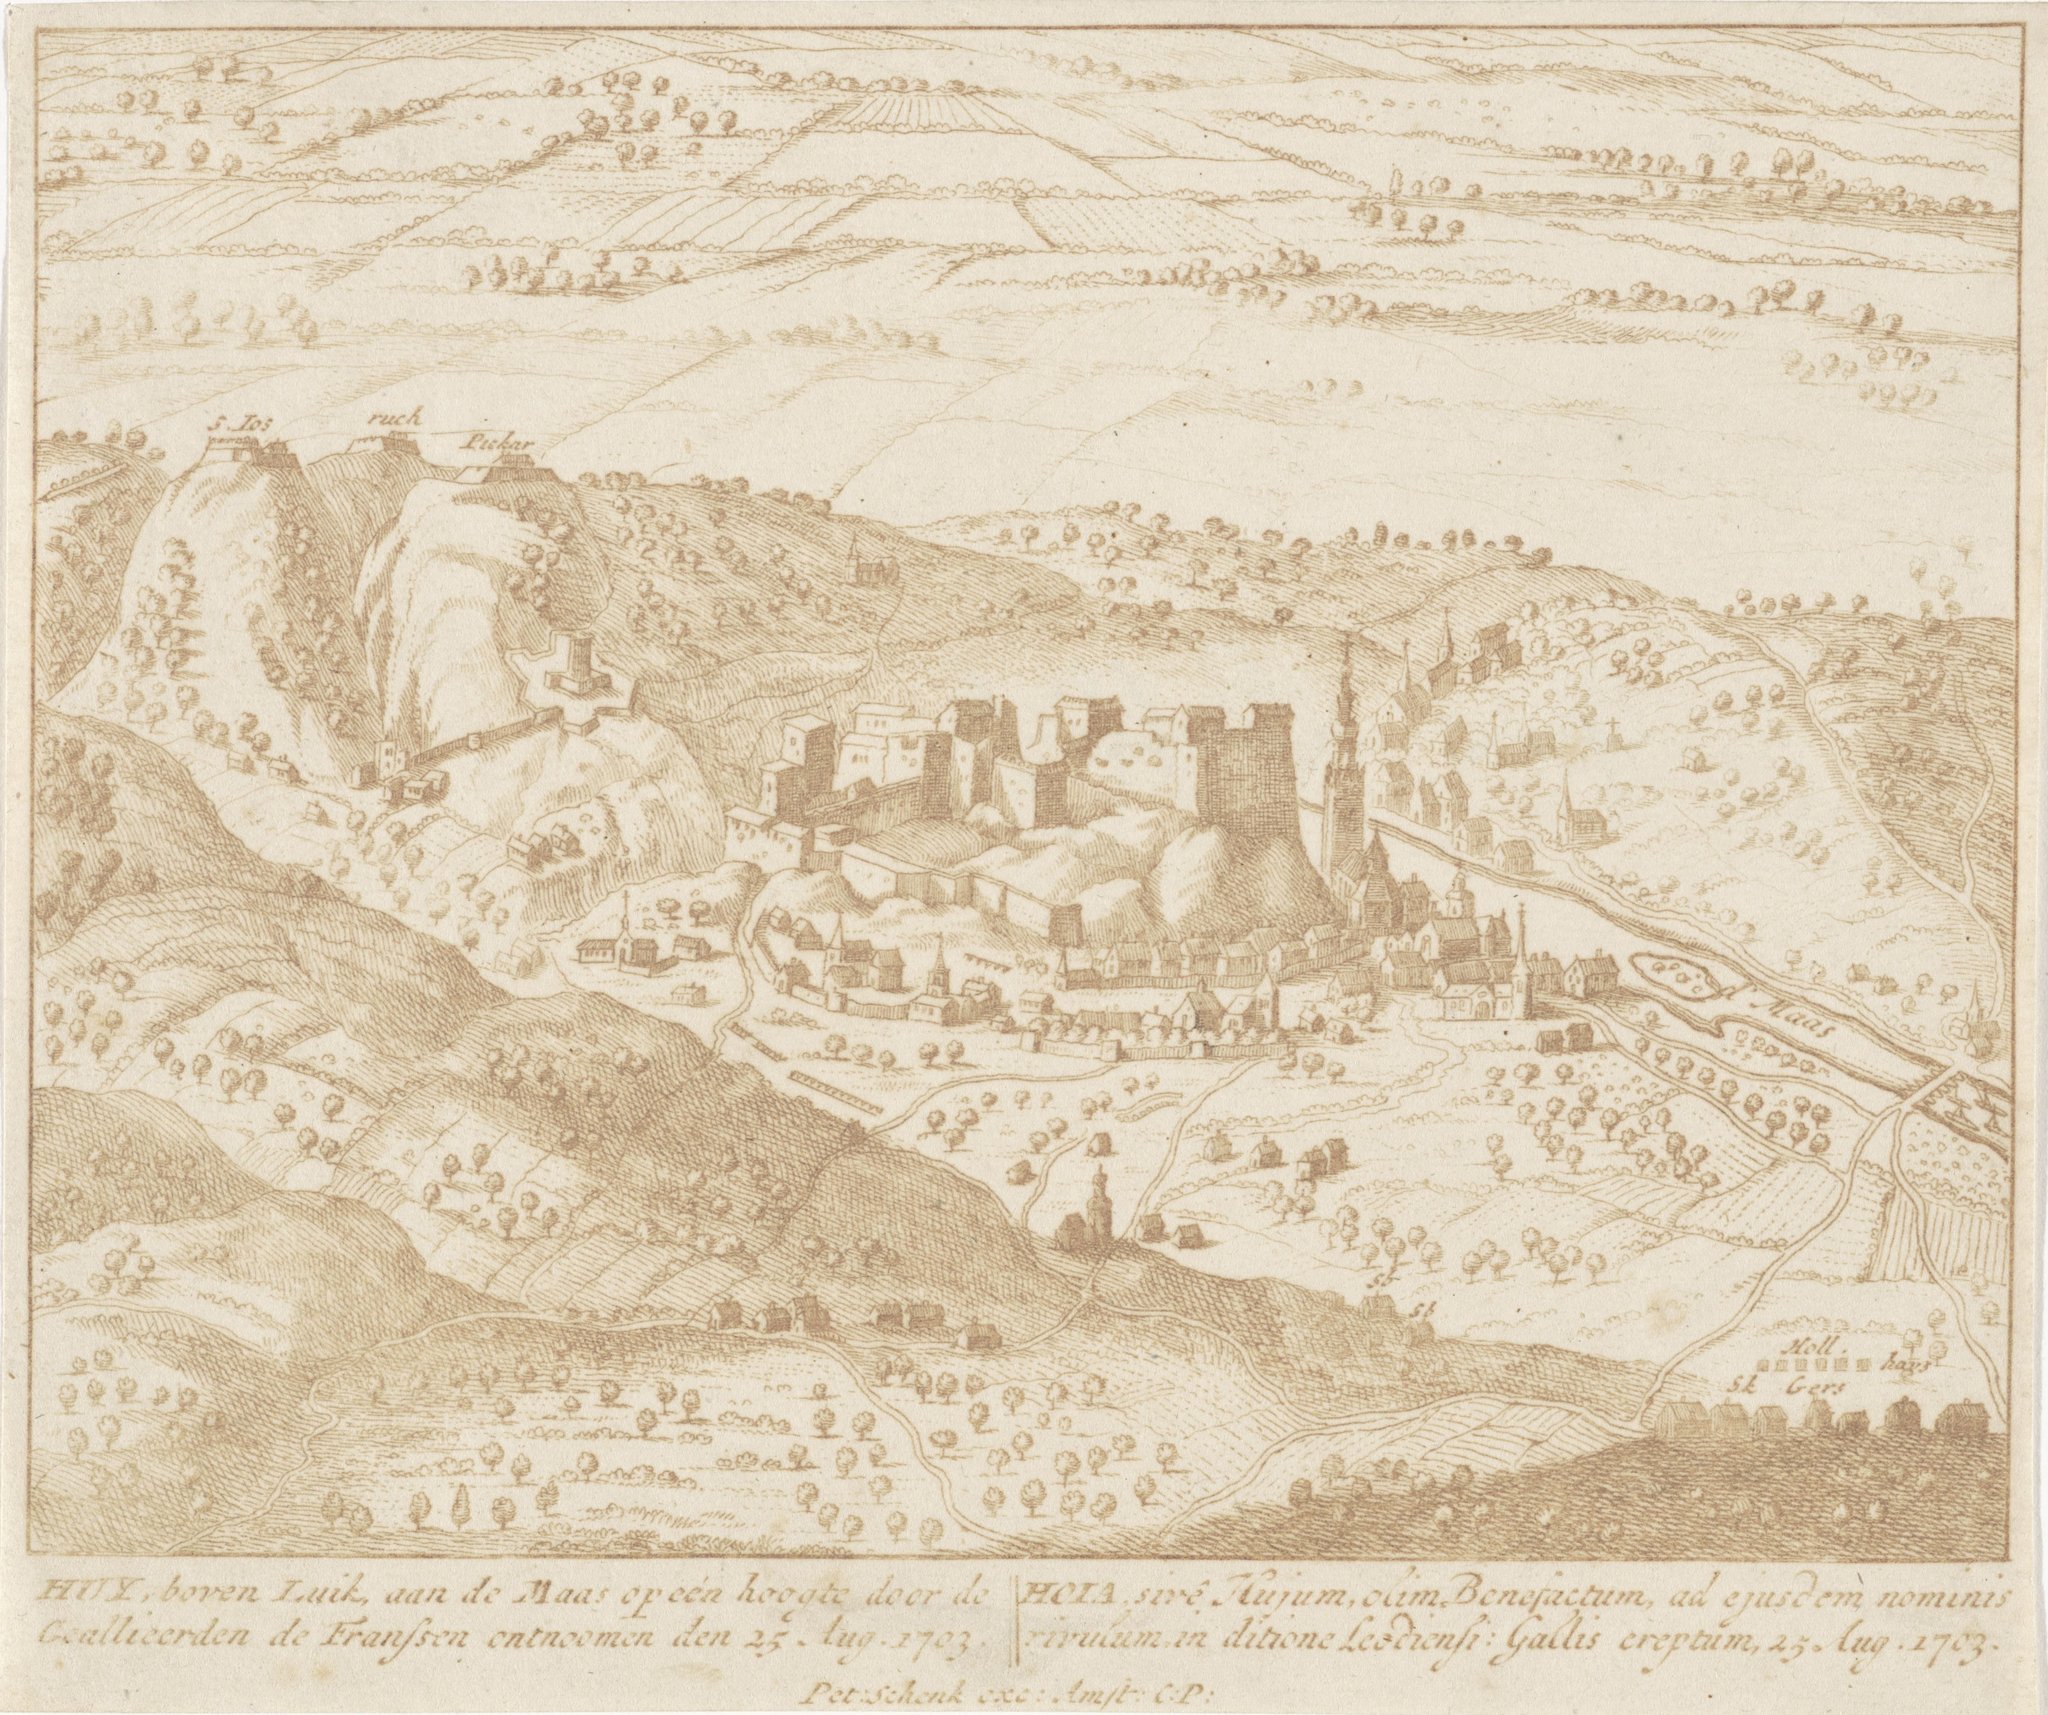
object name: book illustration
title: Schouwburg van den Oorlog, Beginnende van Koning Karel den II. Tot op Koning Karel den III. Bestaande in IX. Historische Figuren op een Olifants Blad, als Veldslagen, Belegeringen te Water en te Lande, met de voornaamste Vestingen (...)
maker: pieter schenk (i)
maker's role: print maker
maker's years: 1660-1711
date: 1706-1727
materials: paper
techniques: etching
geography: amsterdam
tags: landscapes in the temperate zone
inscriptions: collector's mark: Lugt 2228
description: Afbeelding op blad IV uit een van de edities van: Schouwburg van den Oorlog, Beginnende van Koning Karel den II. Tot op Koning Karel den III. Bestaande in IX. Historische Figuren op een Olifants Blad, als Veldslagen, Belegeringen te Water en te Lande, met de voornaamste Vestingen (...) / Theatrum Bellicum, incipiens a Carolo II. Hispaniarum Rege ad Carolum III. 1706-1727.